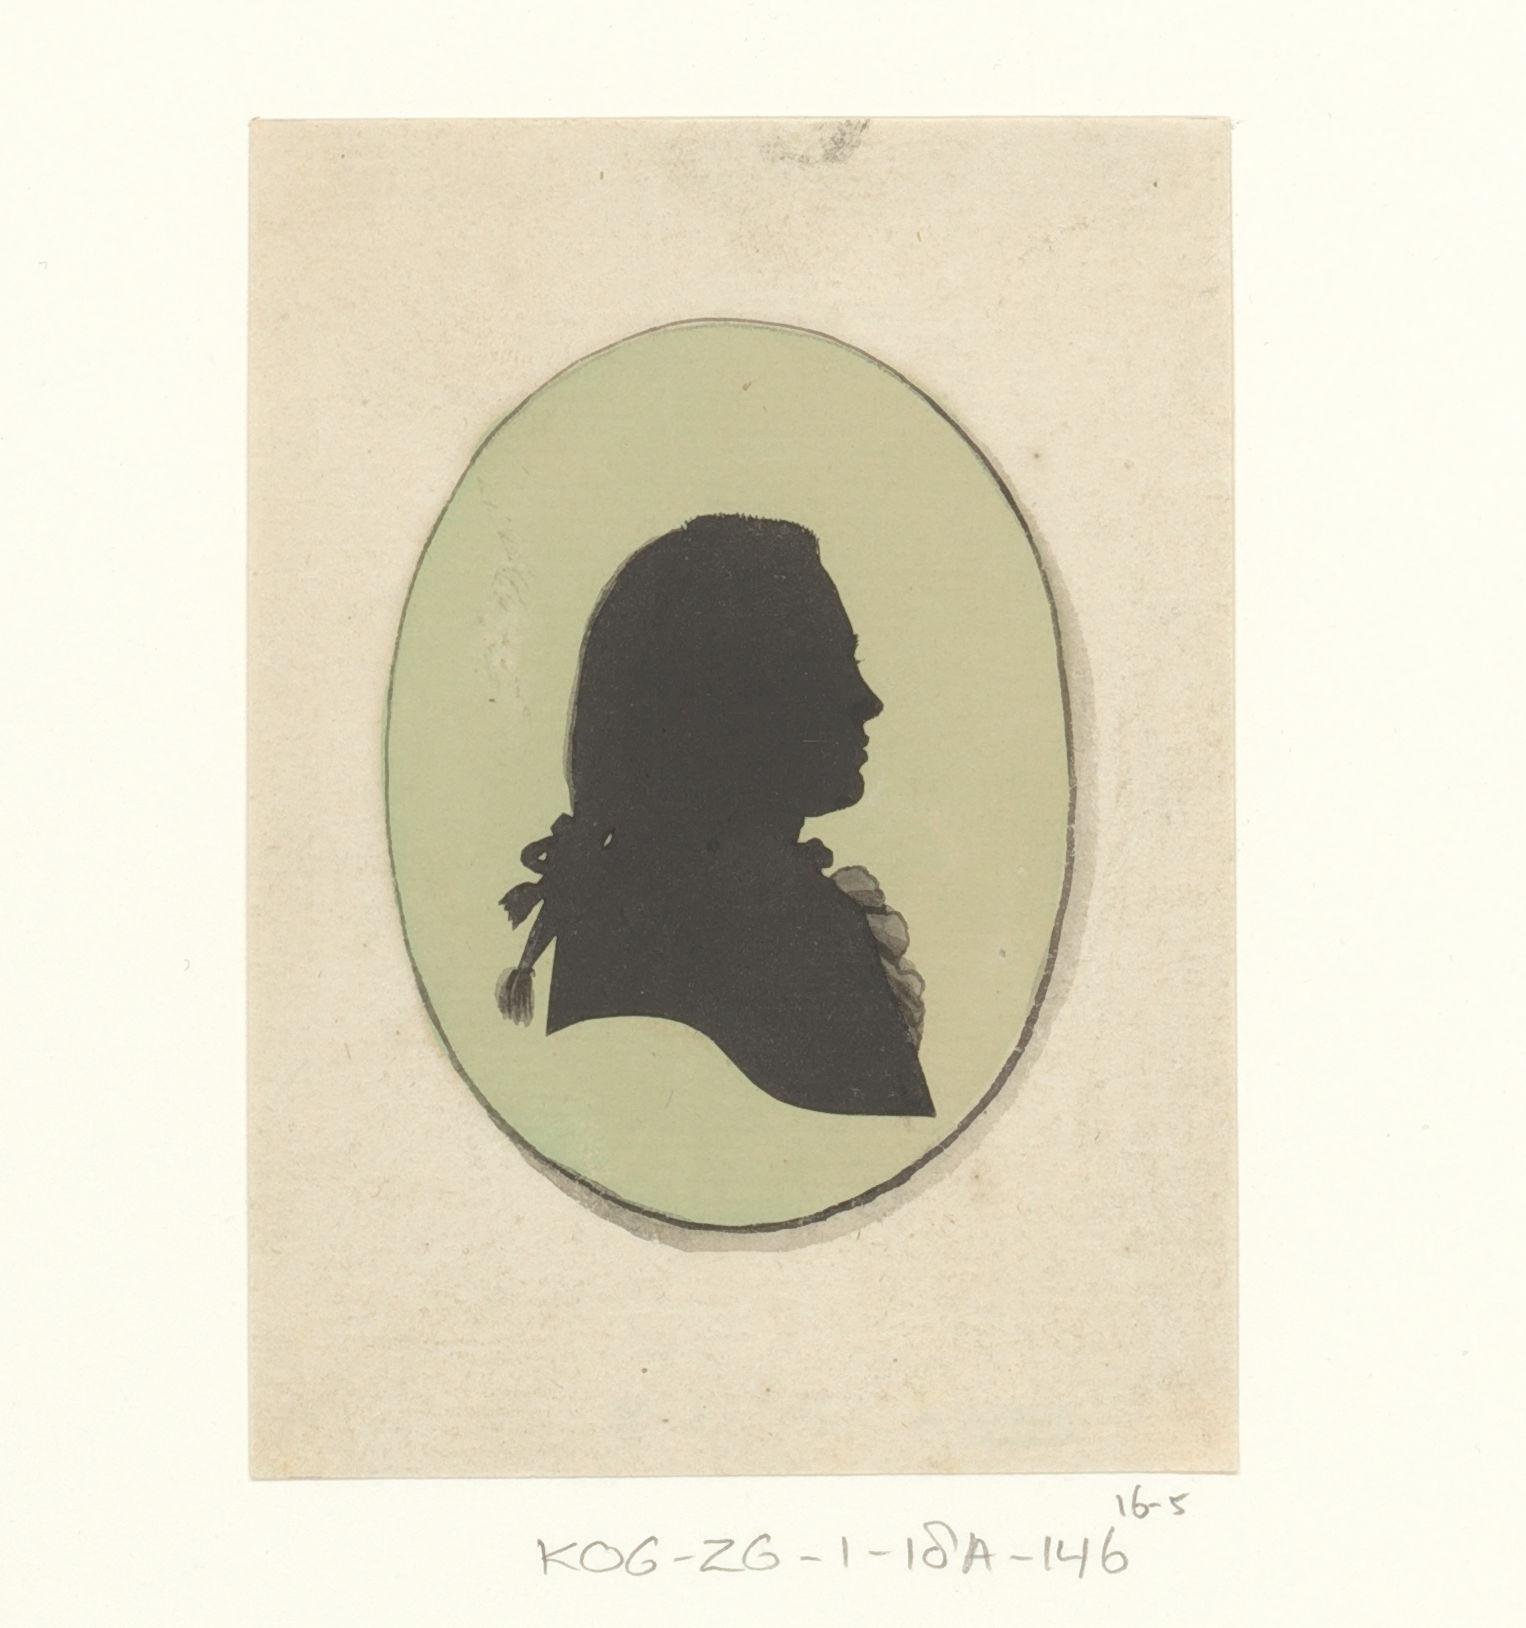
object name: cut paper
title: Silhouetportret van een onbekende man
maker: joseph adolf schmetterling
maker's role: draughtsman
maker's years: 1751-1828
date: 1785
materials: paint, paper, pencil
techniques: brush, snipping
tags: historical persons not known by name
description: Borststuk van een heer en profil met pruik en jabot. Onderwerpsrubrieken binnen de Atlas Zeden en Gewoonten: Schoone kunsten, Silhouetportretten.